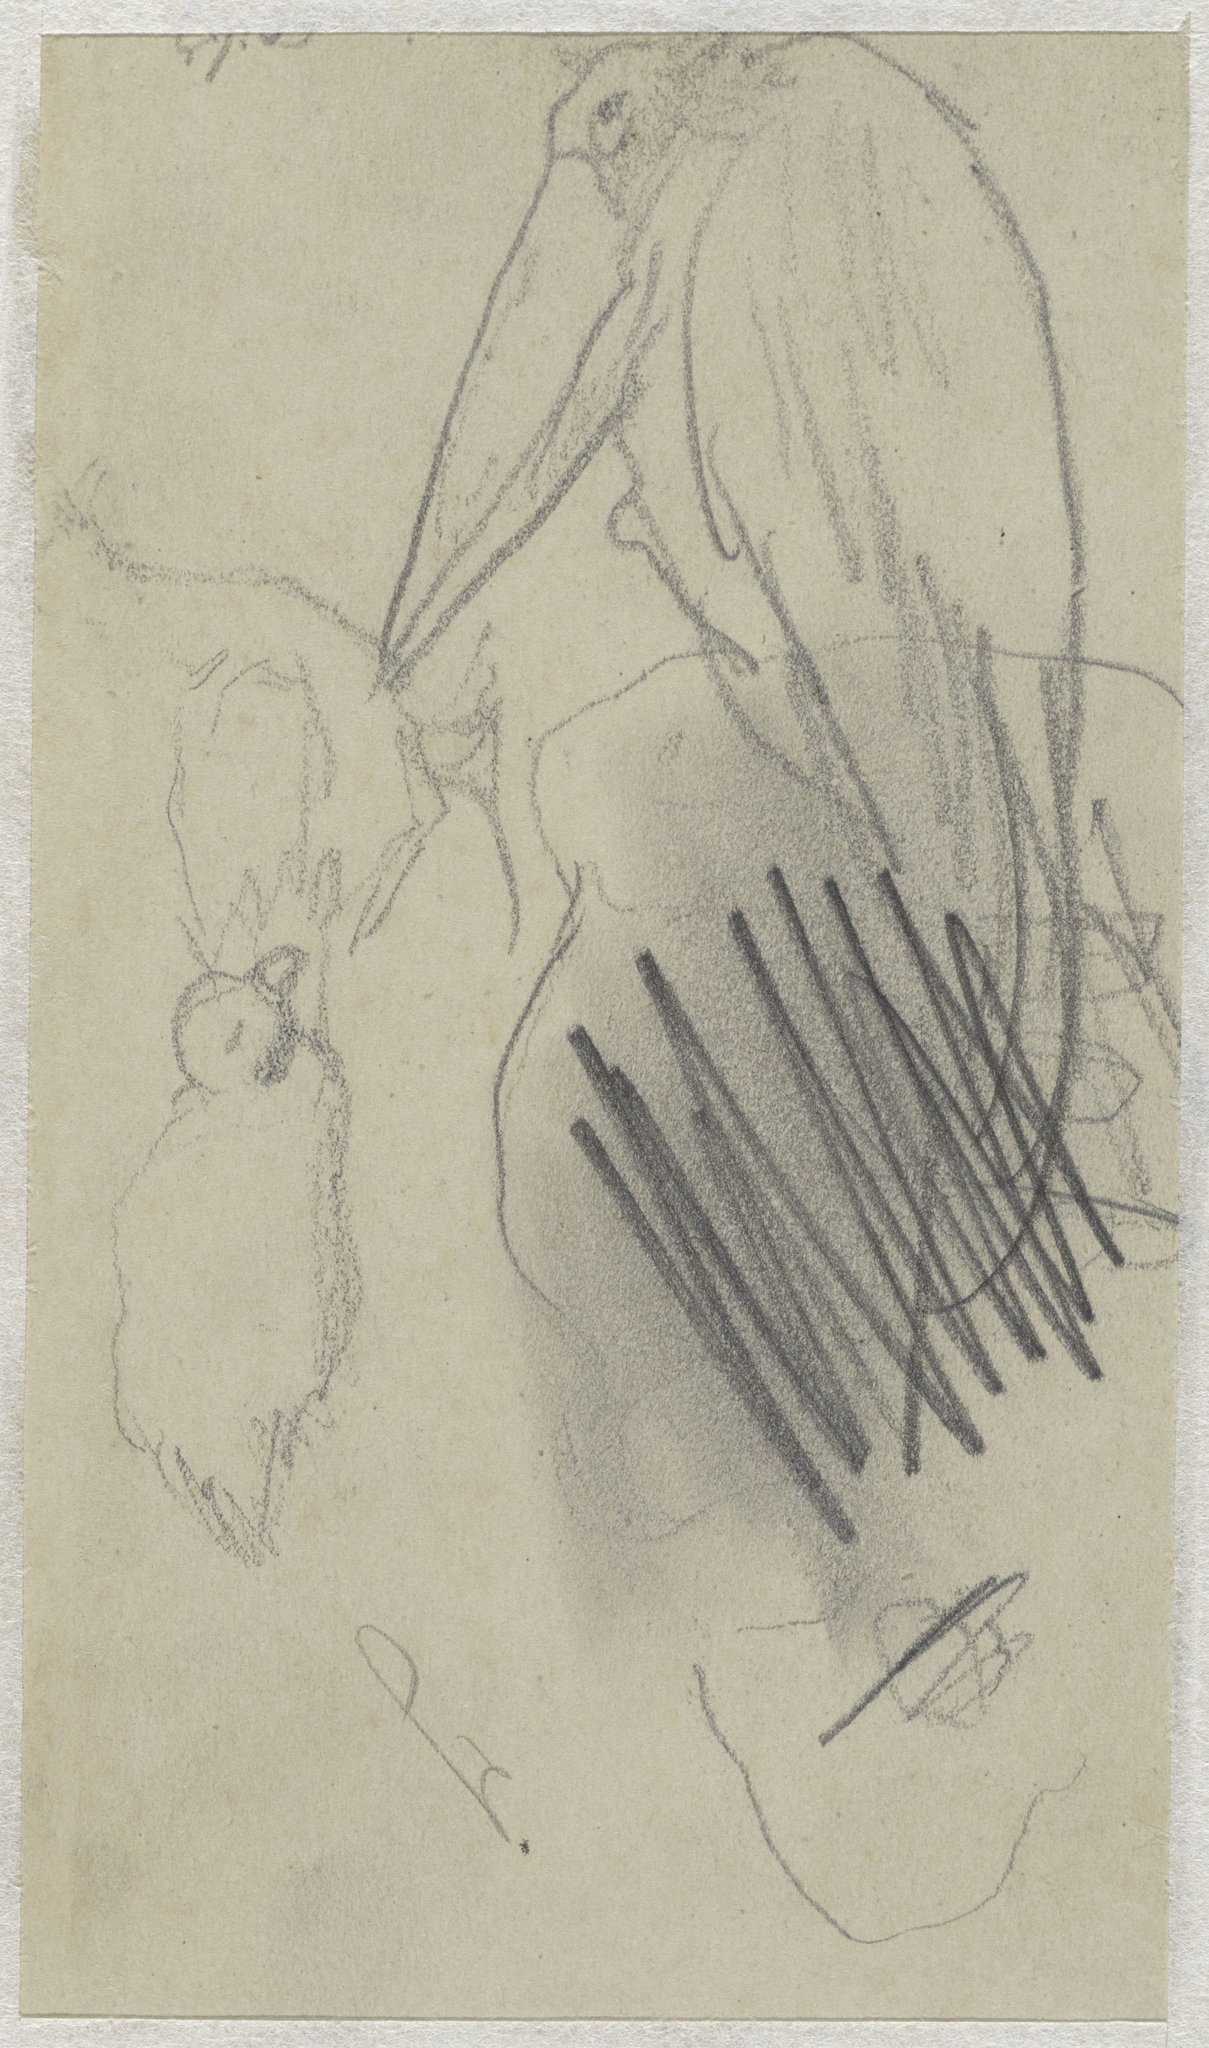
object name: drawing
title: Schetsen van vogels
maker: jacob maris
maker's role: draughtsman, painter, print maker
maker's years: 1837-1899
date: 1847-1899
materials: paper, pencil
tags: birds